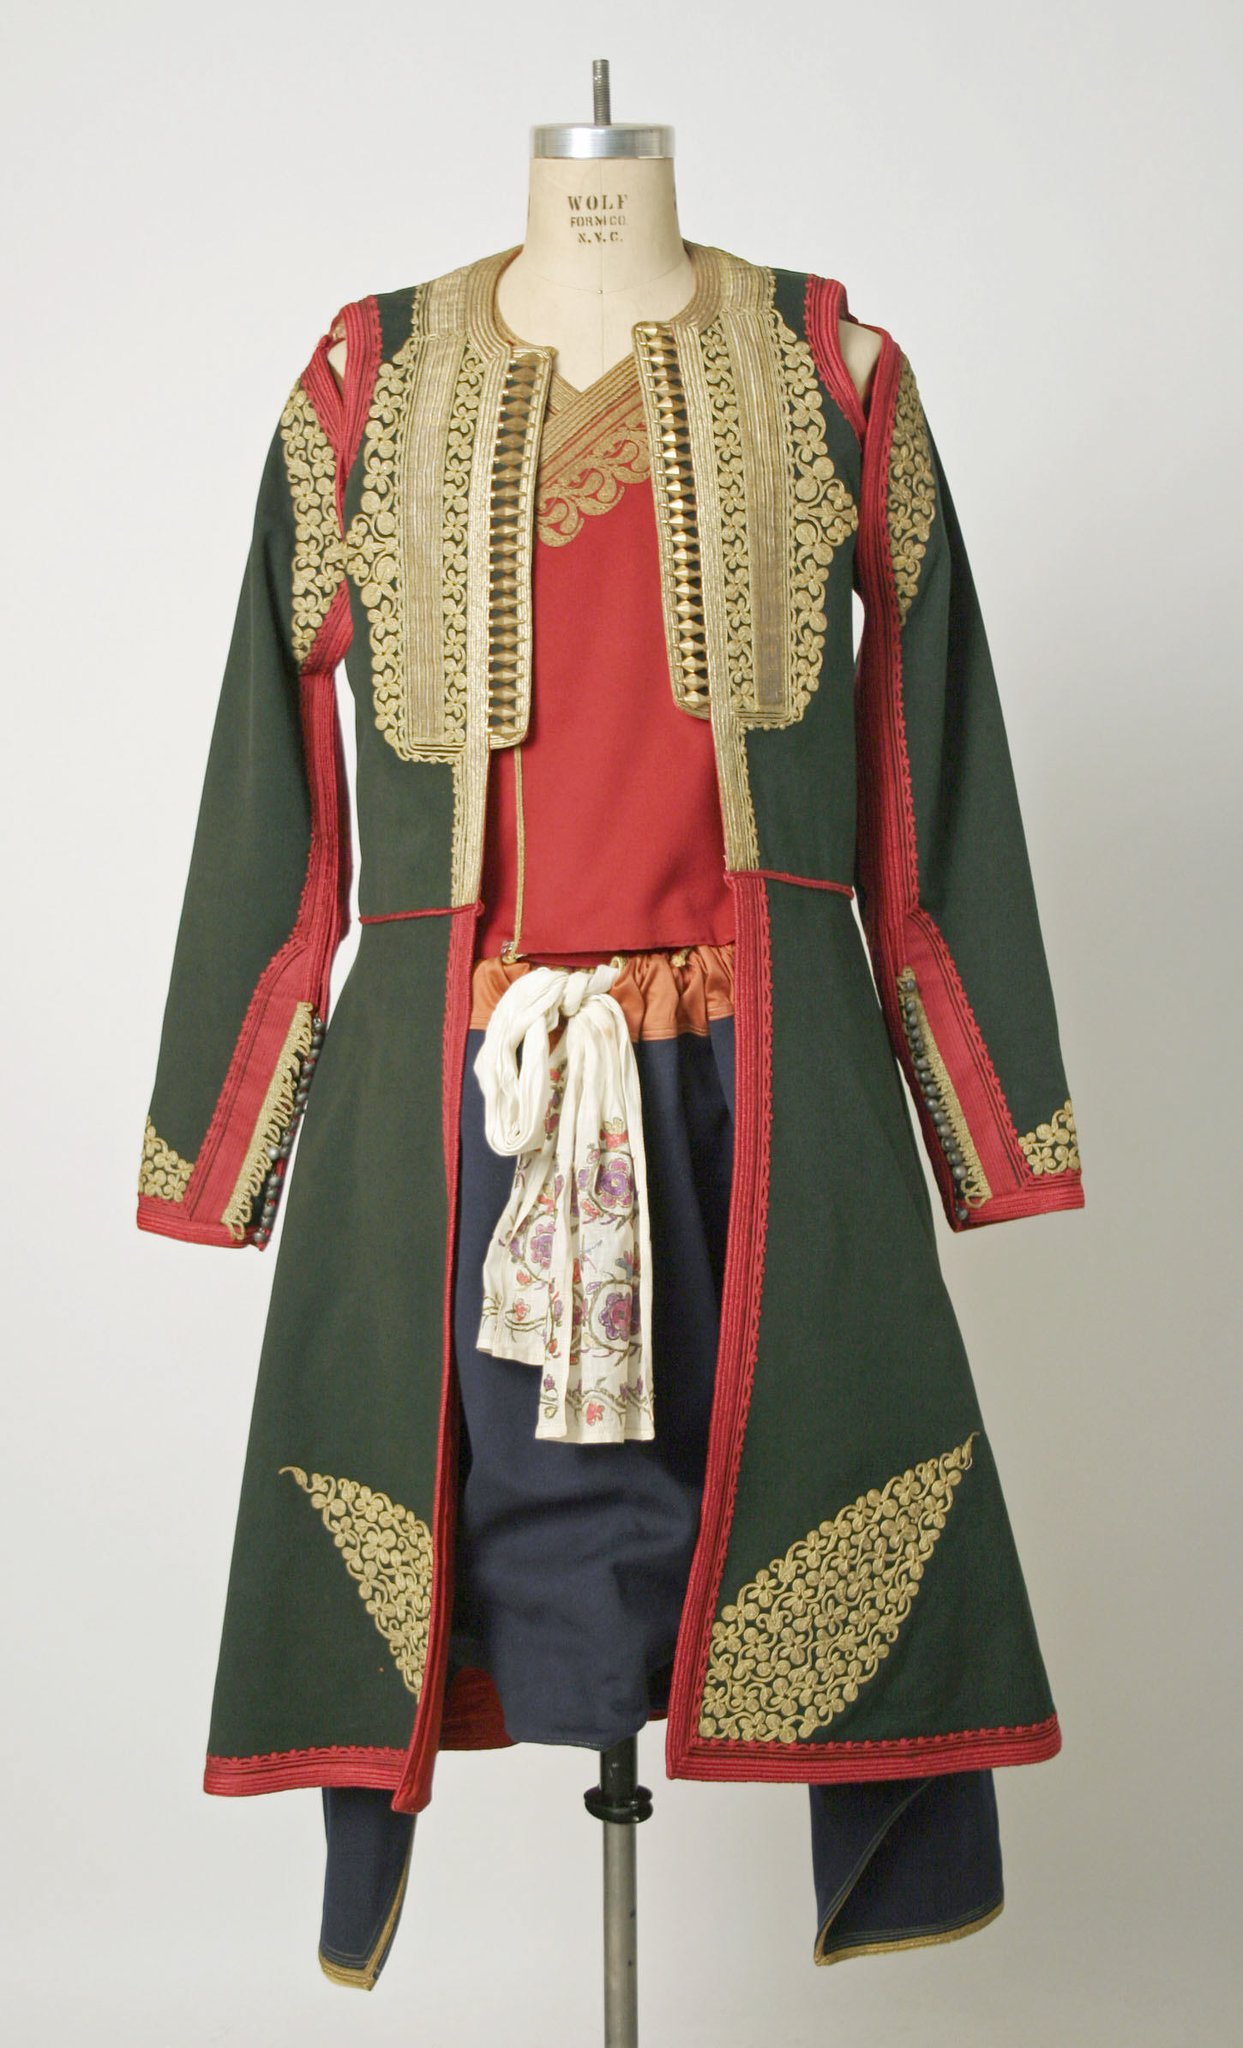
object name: ensemble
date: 1867-1900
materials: linen, silk, wool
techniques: embroidery